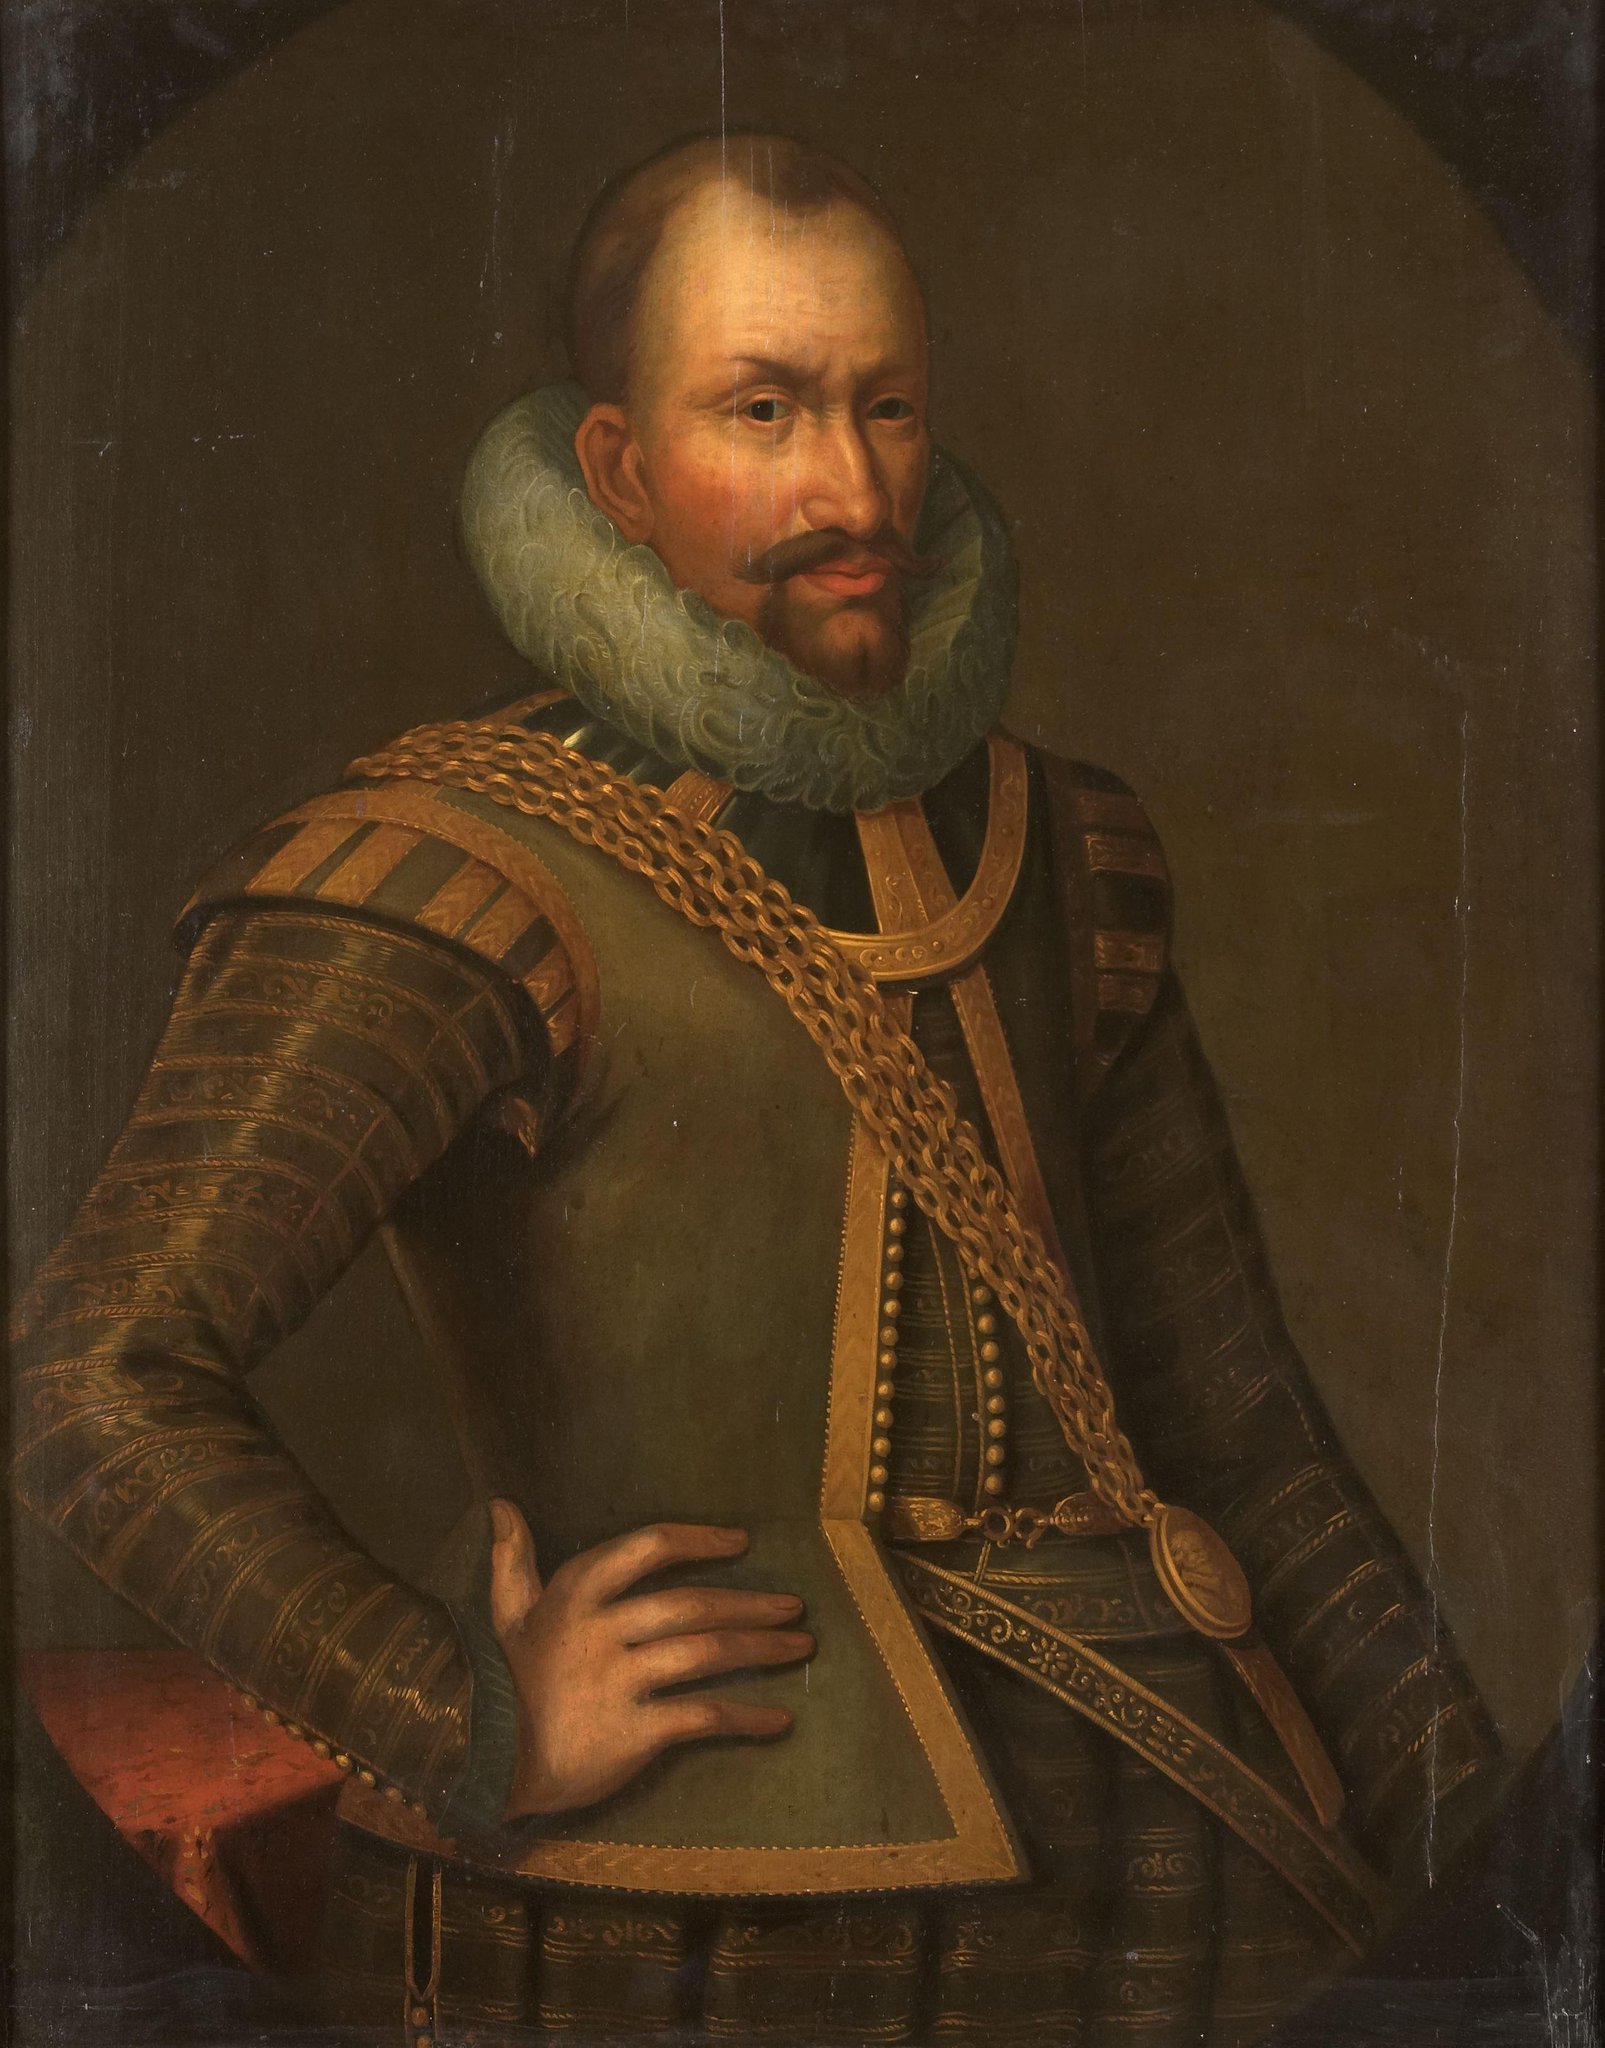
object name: painting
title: Portrait of Gerard Reynst, Governor-General of the Dutch East Indies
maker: Anonymous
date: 1614-1675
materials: oil, panel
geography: batavia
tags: amsterdam, colonial governor, historical persons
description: Portret van Gerard Reynst (gest. 1615). Gouverneur-generaal (1614-15). Staand, ten halven lijve naar rechts, de rechterhand in de zij. Om de schouder een gouden keten met een portretmedaillon van prins Maurits.